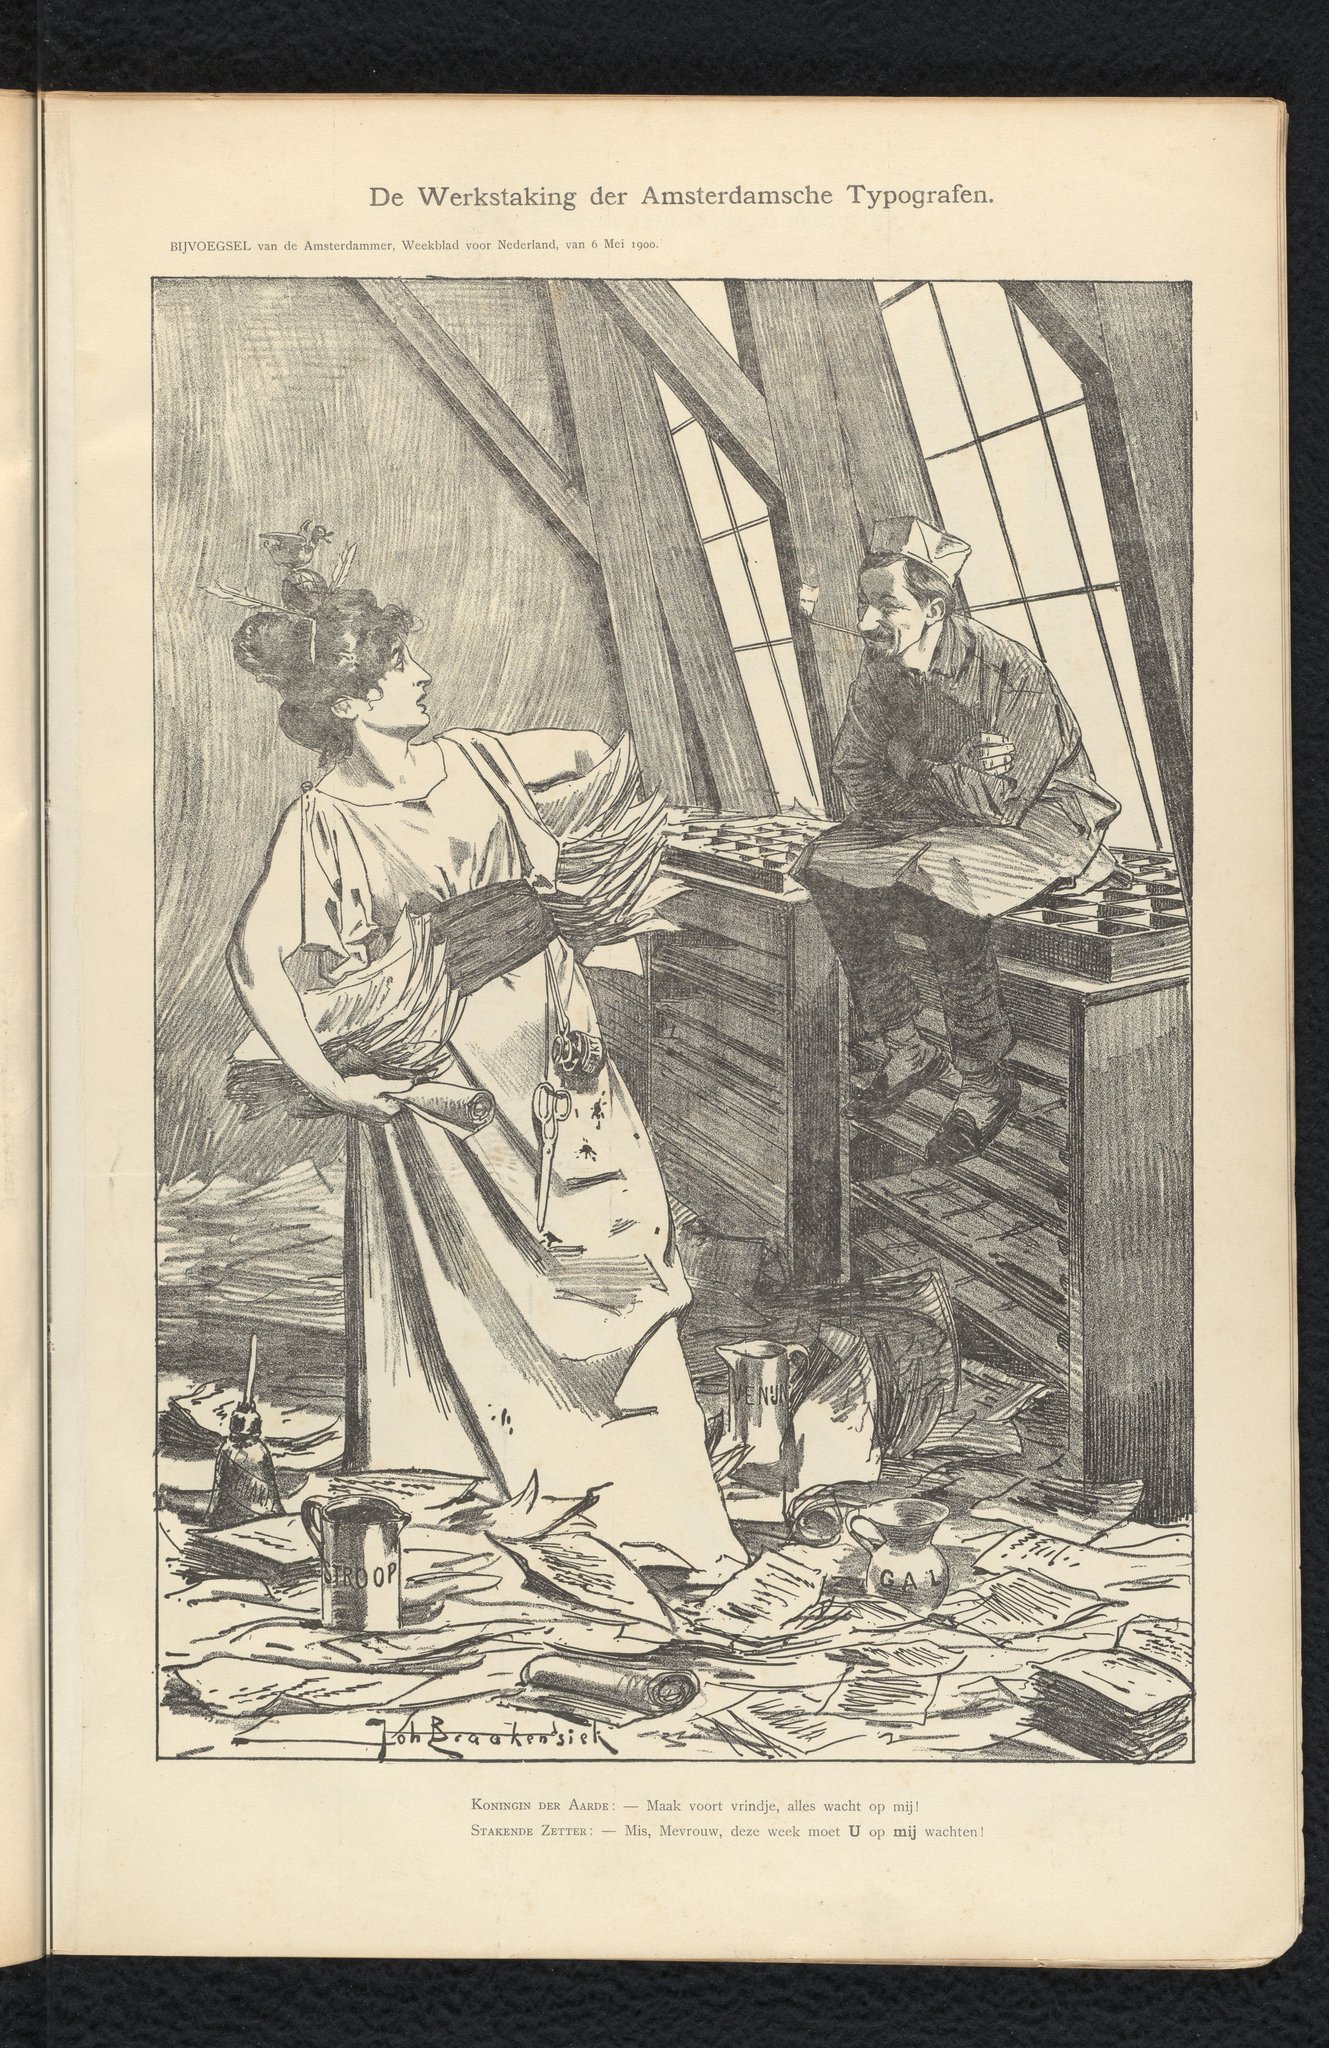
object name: cartoon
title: De Werkstaking der Amsterdamsche Typografen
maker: johan braakensiek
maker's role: draughtsman, print maker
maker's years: 1858-1940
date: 1900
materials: paper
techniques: lithograph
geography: netherlands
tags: printing type, printing, printing office, strike (political demonstration), political caricatures and satires, 'frau welt'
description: Vrouwe Wereld paniekerig met bundels papieren onder de armen wil dat de zetter aan het werk gaat, maar die staakt en zit op de letterkast met de armen over elkaar een pijp te roken.